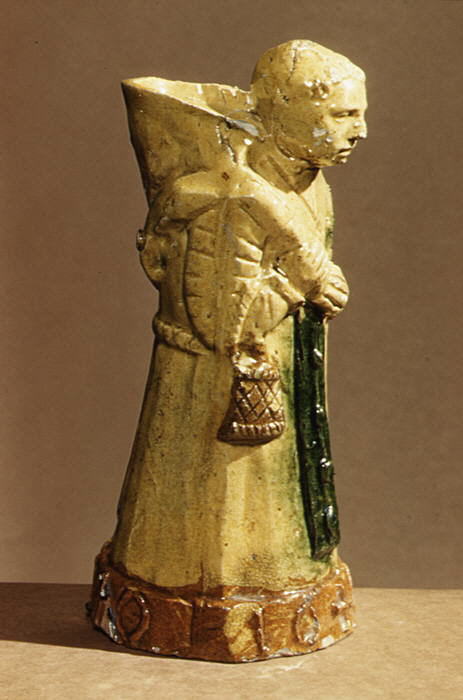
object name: beaker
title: Beaker (one of a pair)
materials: earthenware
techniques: glazing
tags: women